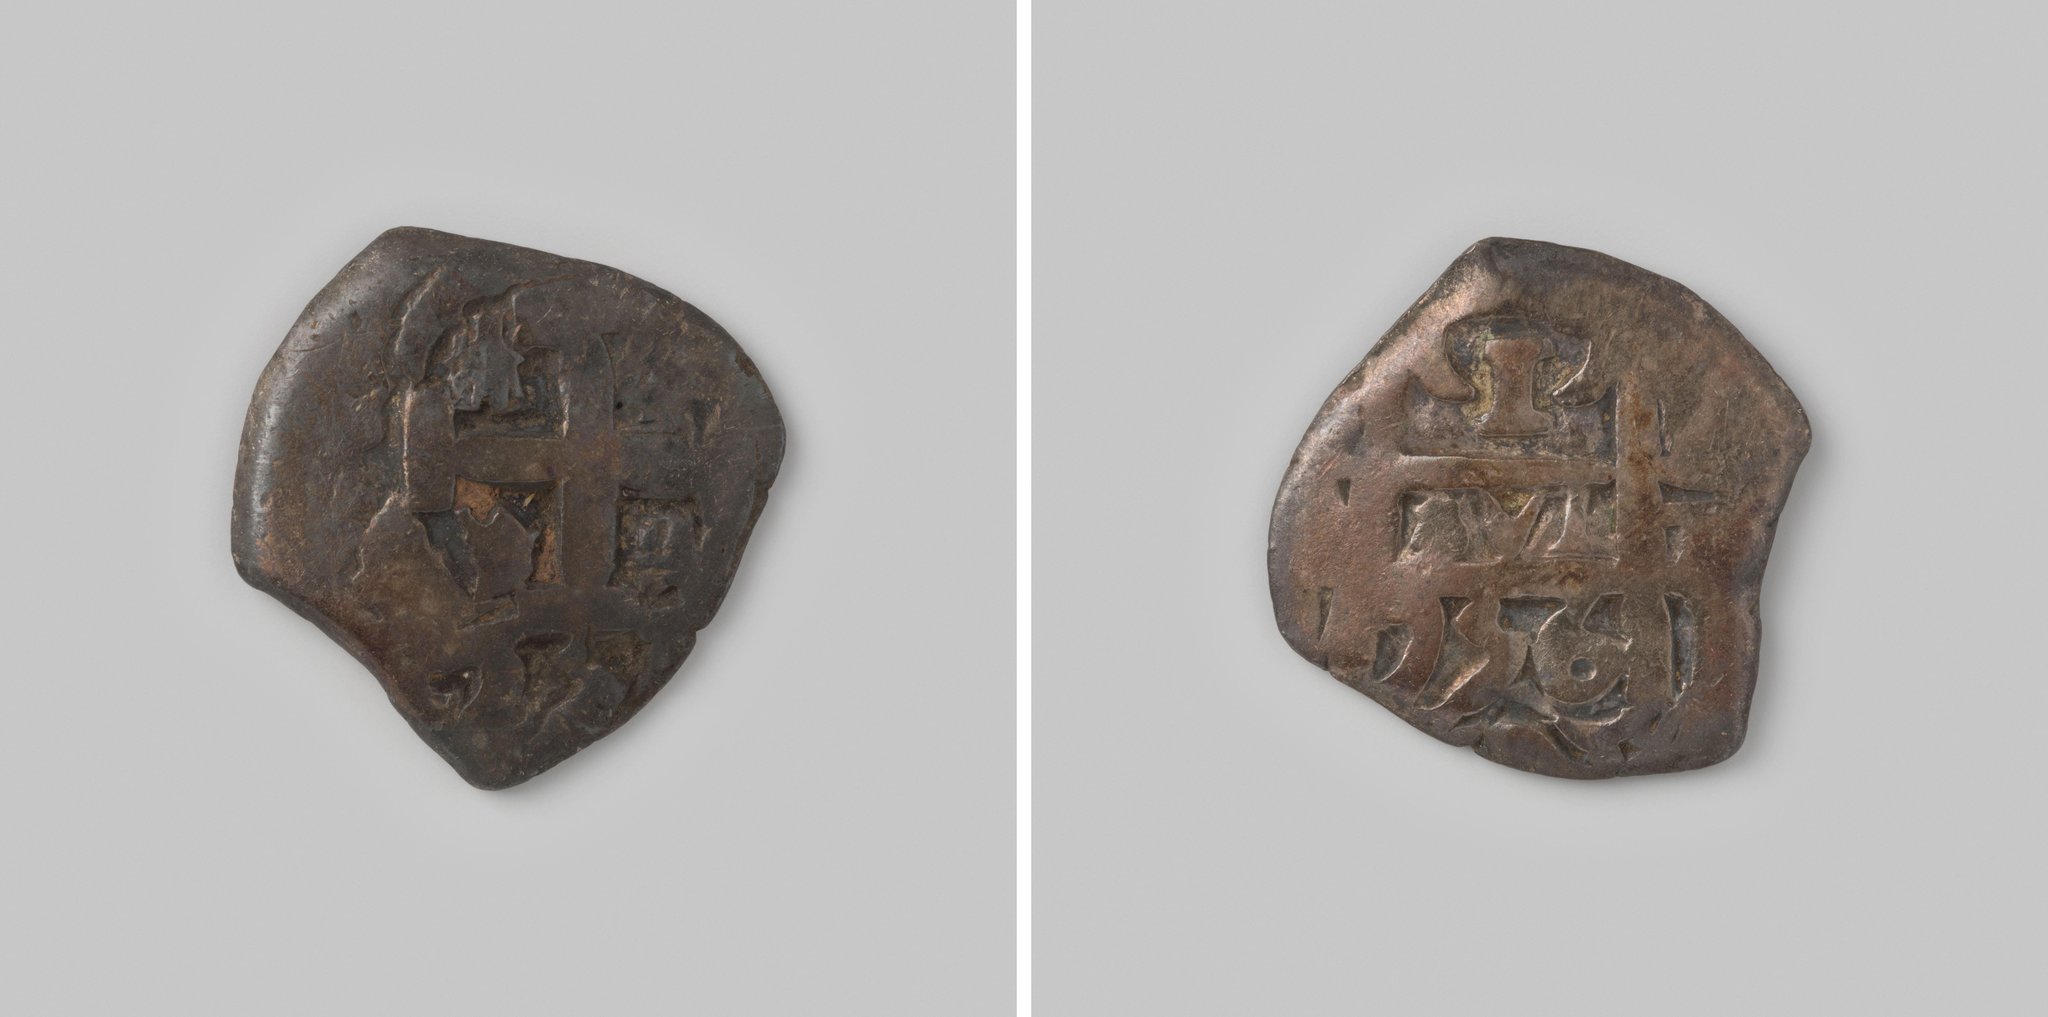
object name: real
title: Bolivia, Ferdinand VI, reaal,1756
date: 1756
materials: silver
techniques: striking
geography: potosi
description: Zilveren munt uit ruw muntplaatje. Voorzijde: binnen vierpas gelijkbenig herkruist kruis met in de hoeken afwisseld een kasteel en een leeuw. Keerzijde: tussen twee uit zee oprijzende zuilen, waarop versiering, in drie regels waarde-aanduiding: I, opschrift en jaartal: 756. Daartussen tweemaal muntplaats-aanduiding: P [=Potosi].